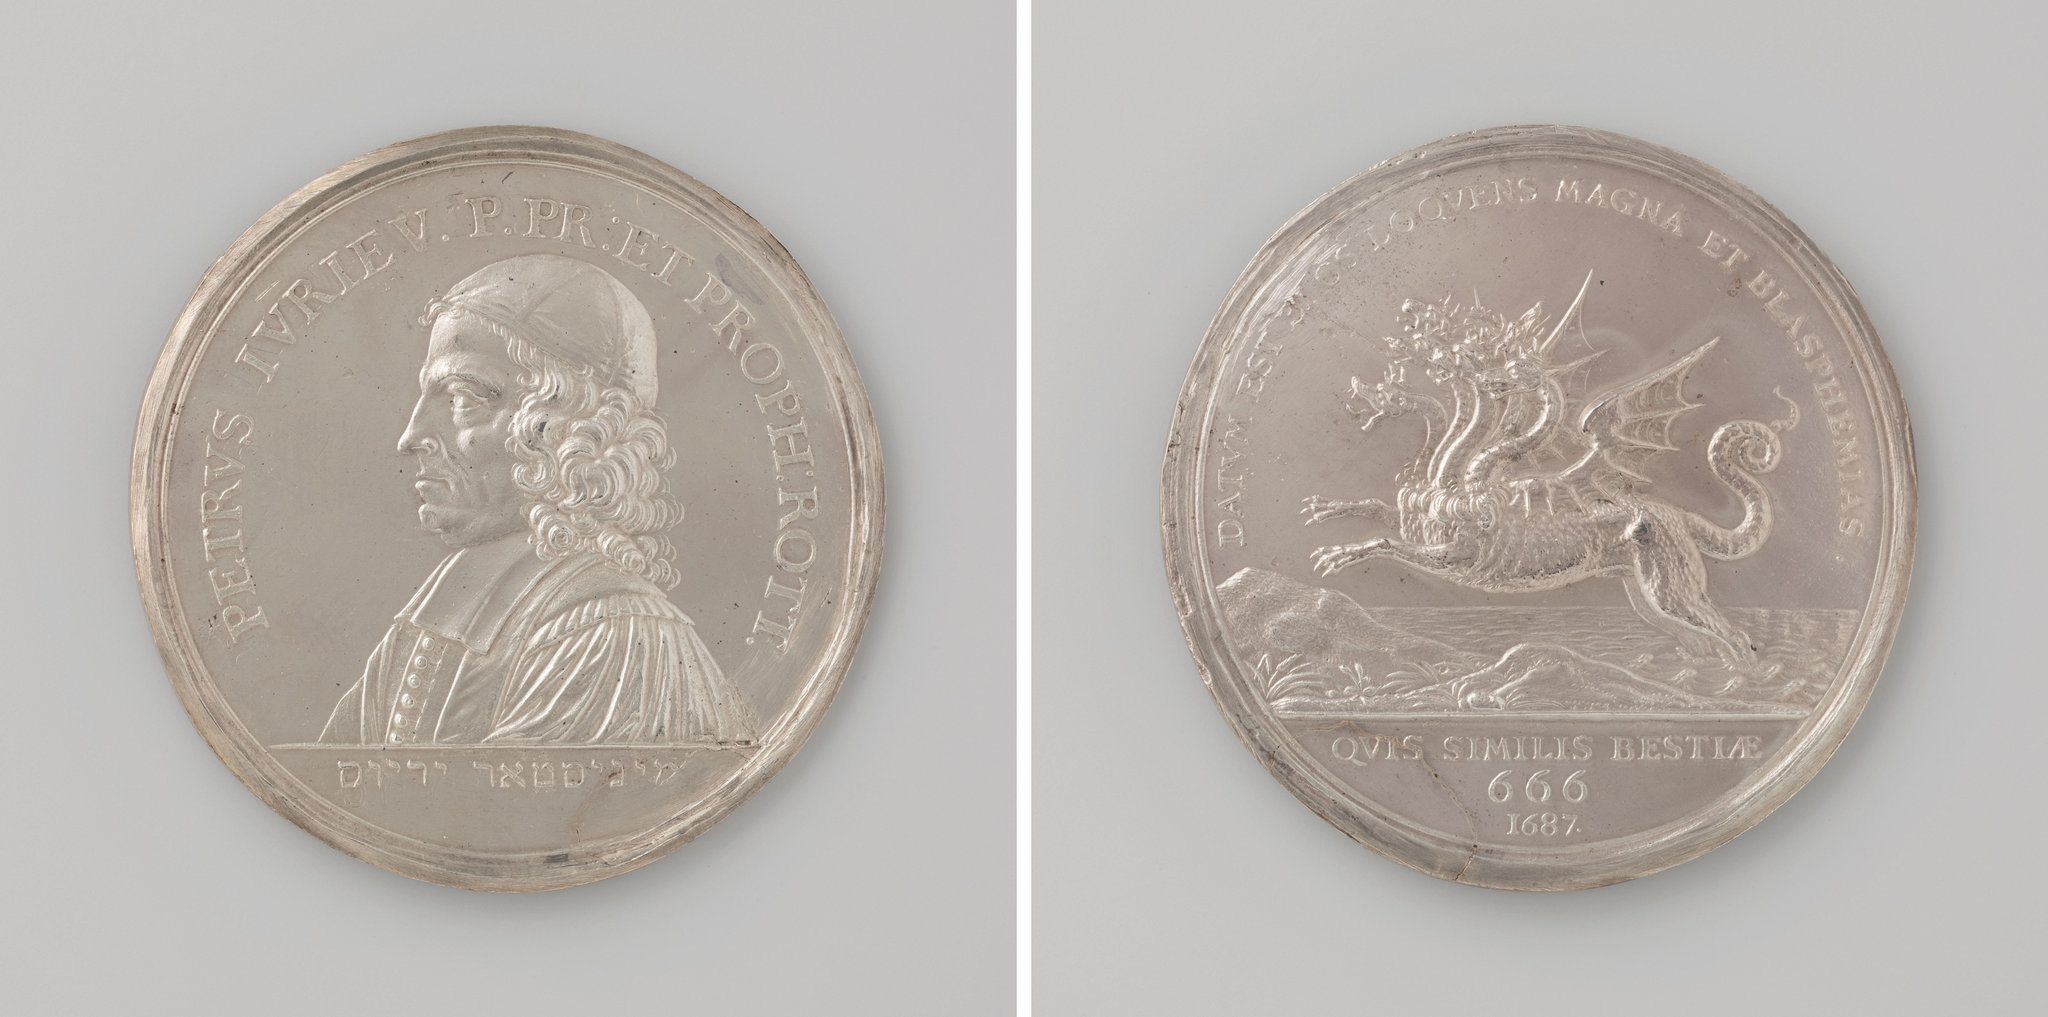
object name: history medal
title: Petrus Jurieu, hoogleraar en predikant van de Waalse gemeente te Rotterdam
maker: Anonymous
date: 1687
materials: silver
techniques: striking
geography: netherlands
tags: rotterdam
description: Zilveren penning. Voorzijde: borststuk man binnen omschrift. Keerzijde: beest opduikend uit zee binnen omschrift; afsnede: opschrift